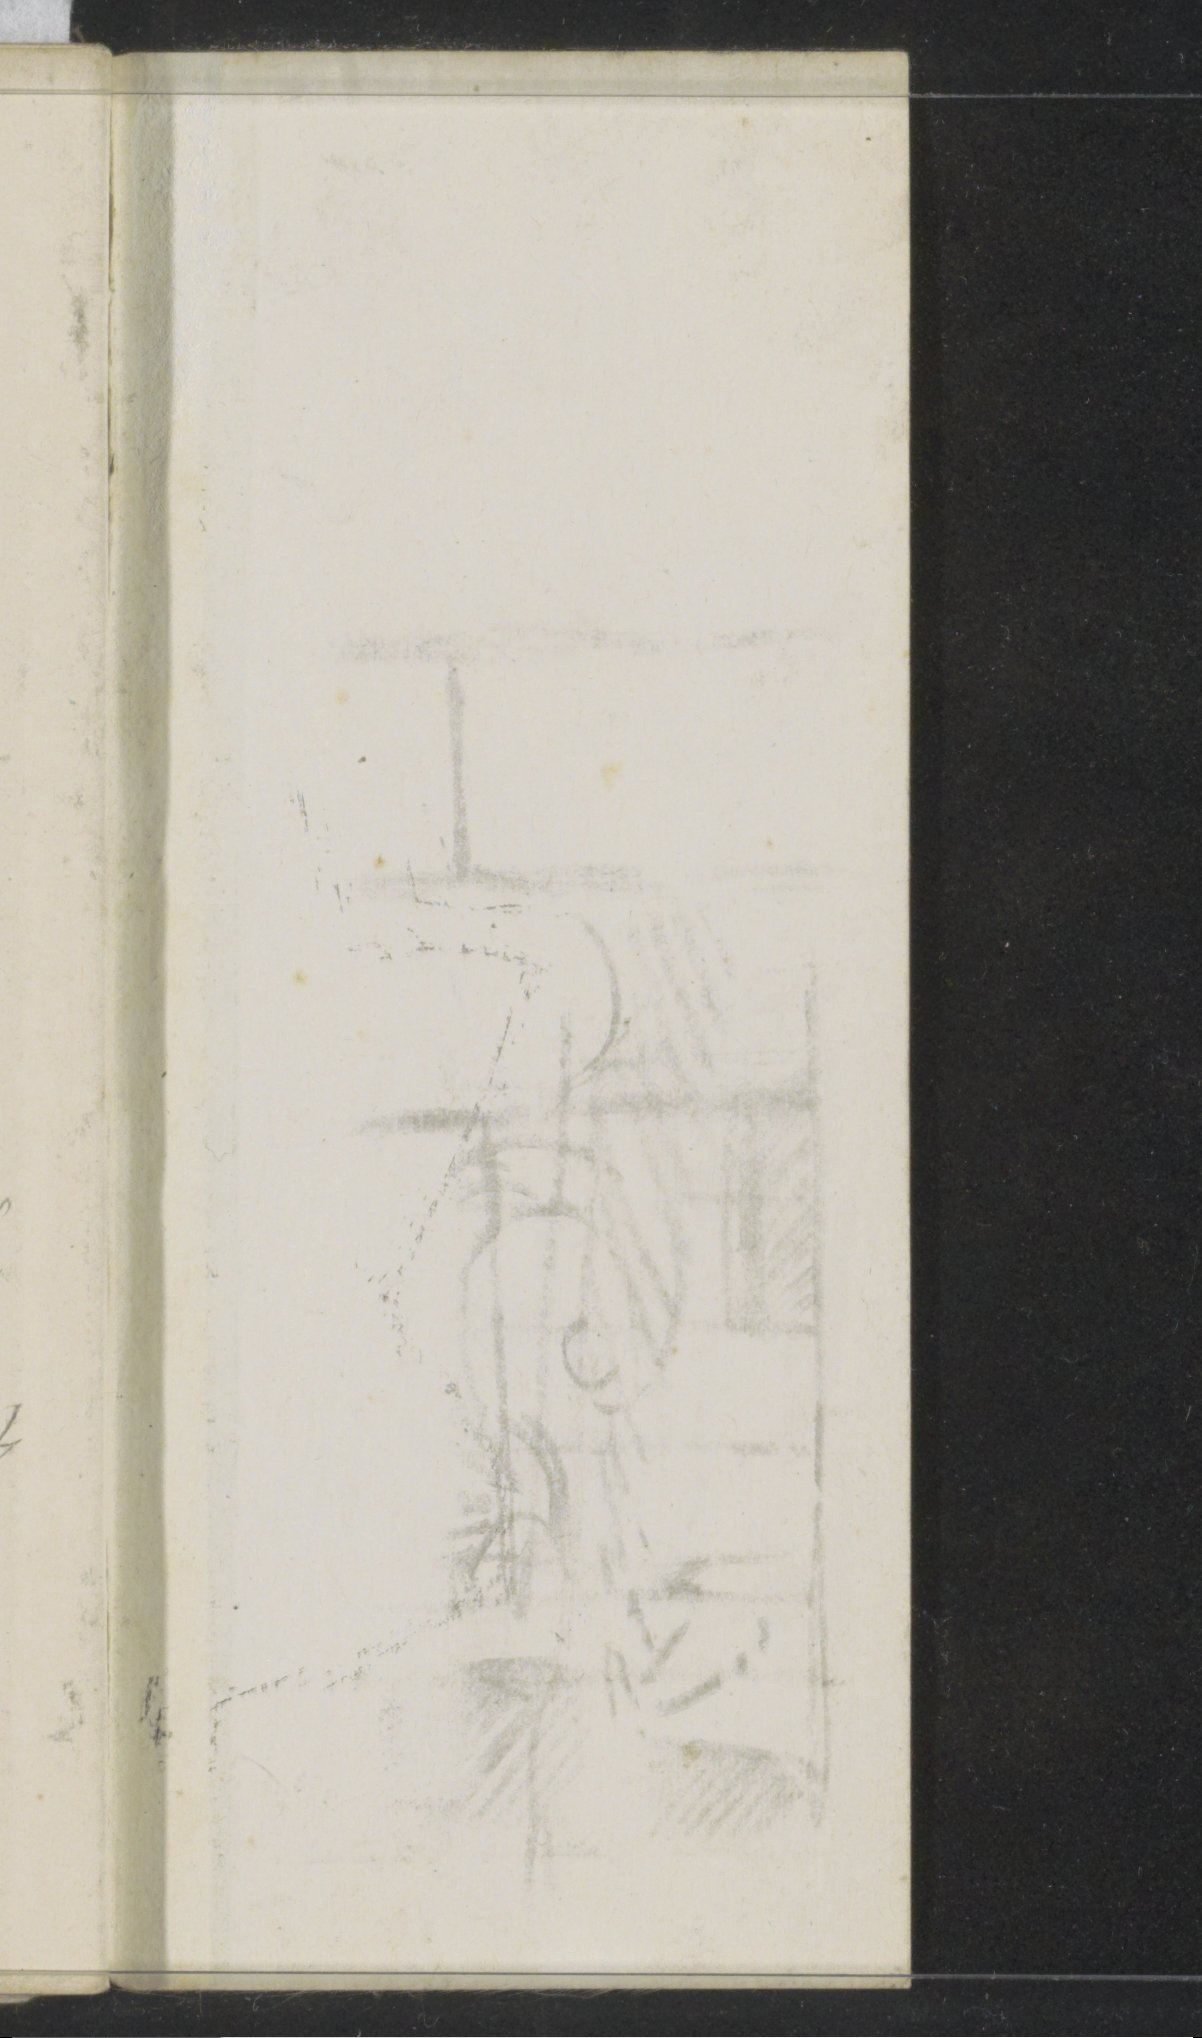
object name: sketchbook leaf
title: Abklatsch van een krijttekening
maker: gerrit willem dijsselhof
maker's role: designer, draughtsman, print maker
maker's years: 1866-1924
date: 1901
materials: paper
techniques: printmaking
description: Achterste schutblad uit een schetsboek met 42 bladzijden.